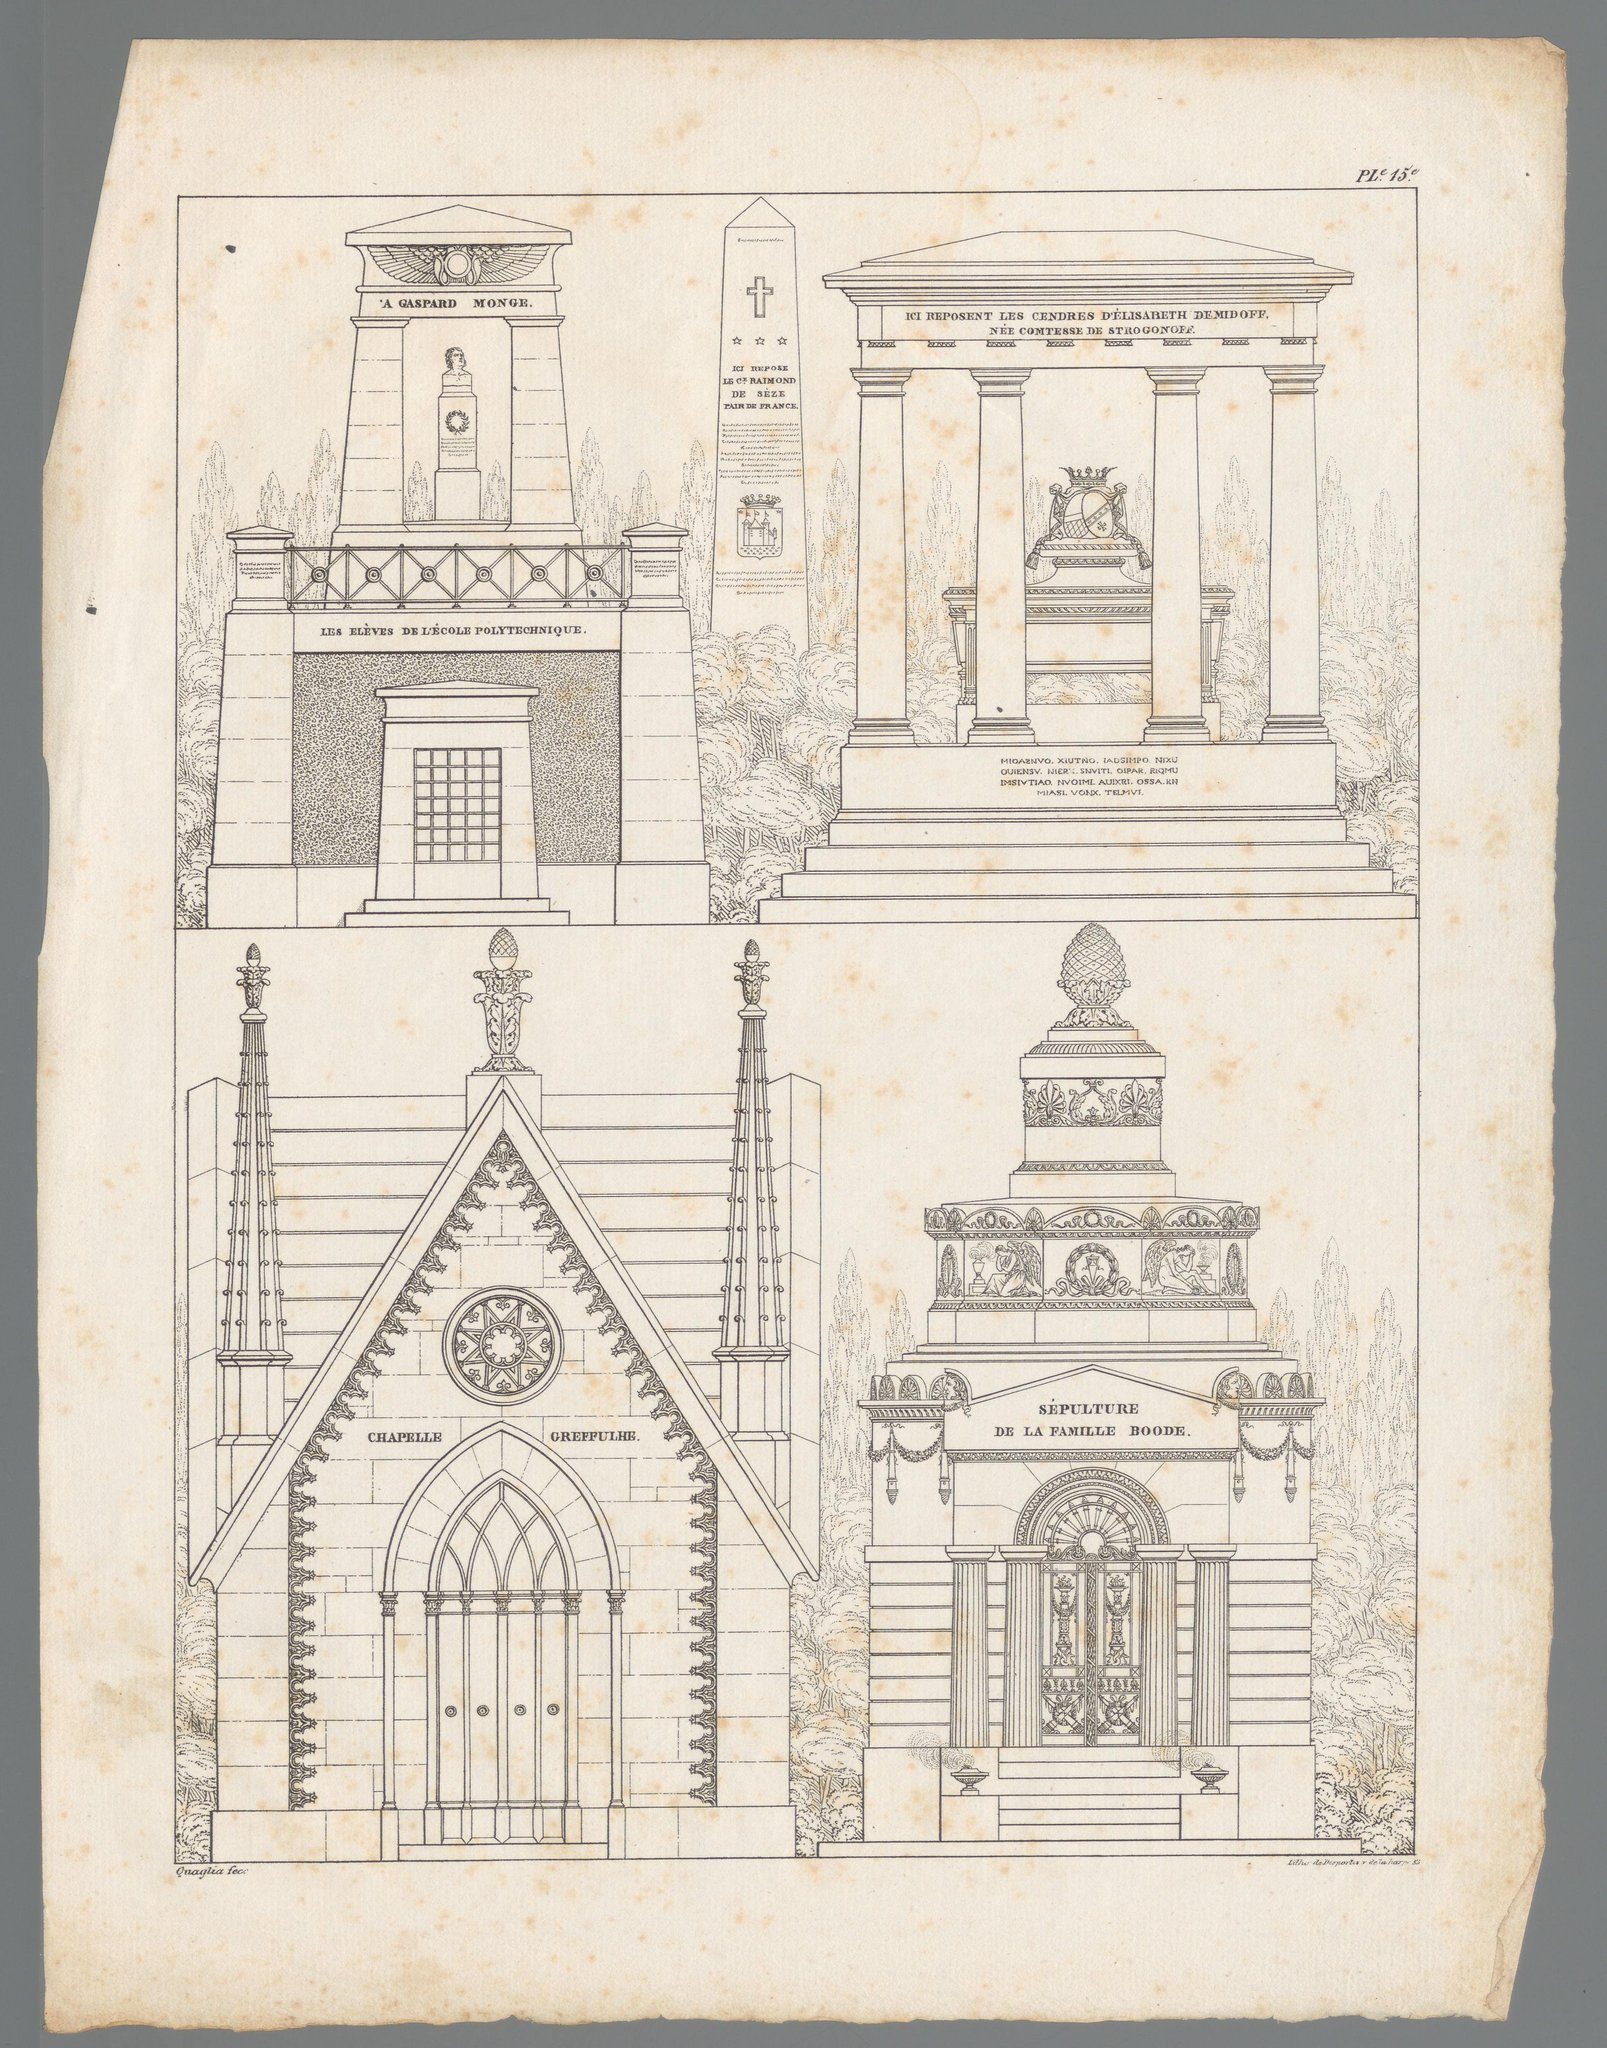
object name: print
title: Vijf grafmonumenten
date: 1803-1869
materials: paper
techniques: lithograph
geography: paris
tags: cemetery, park-like burying ground